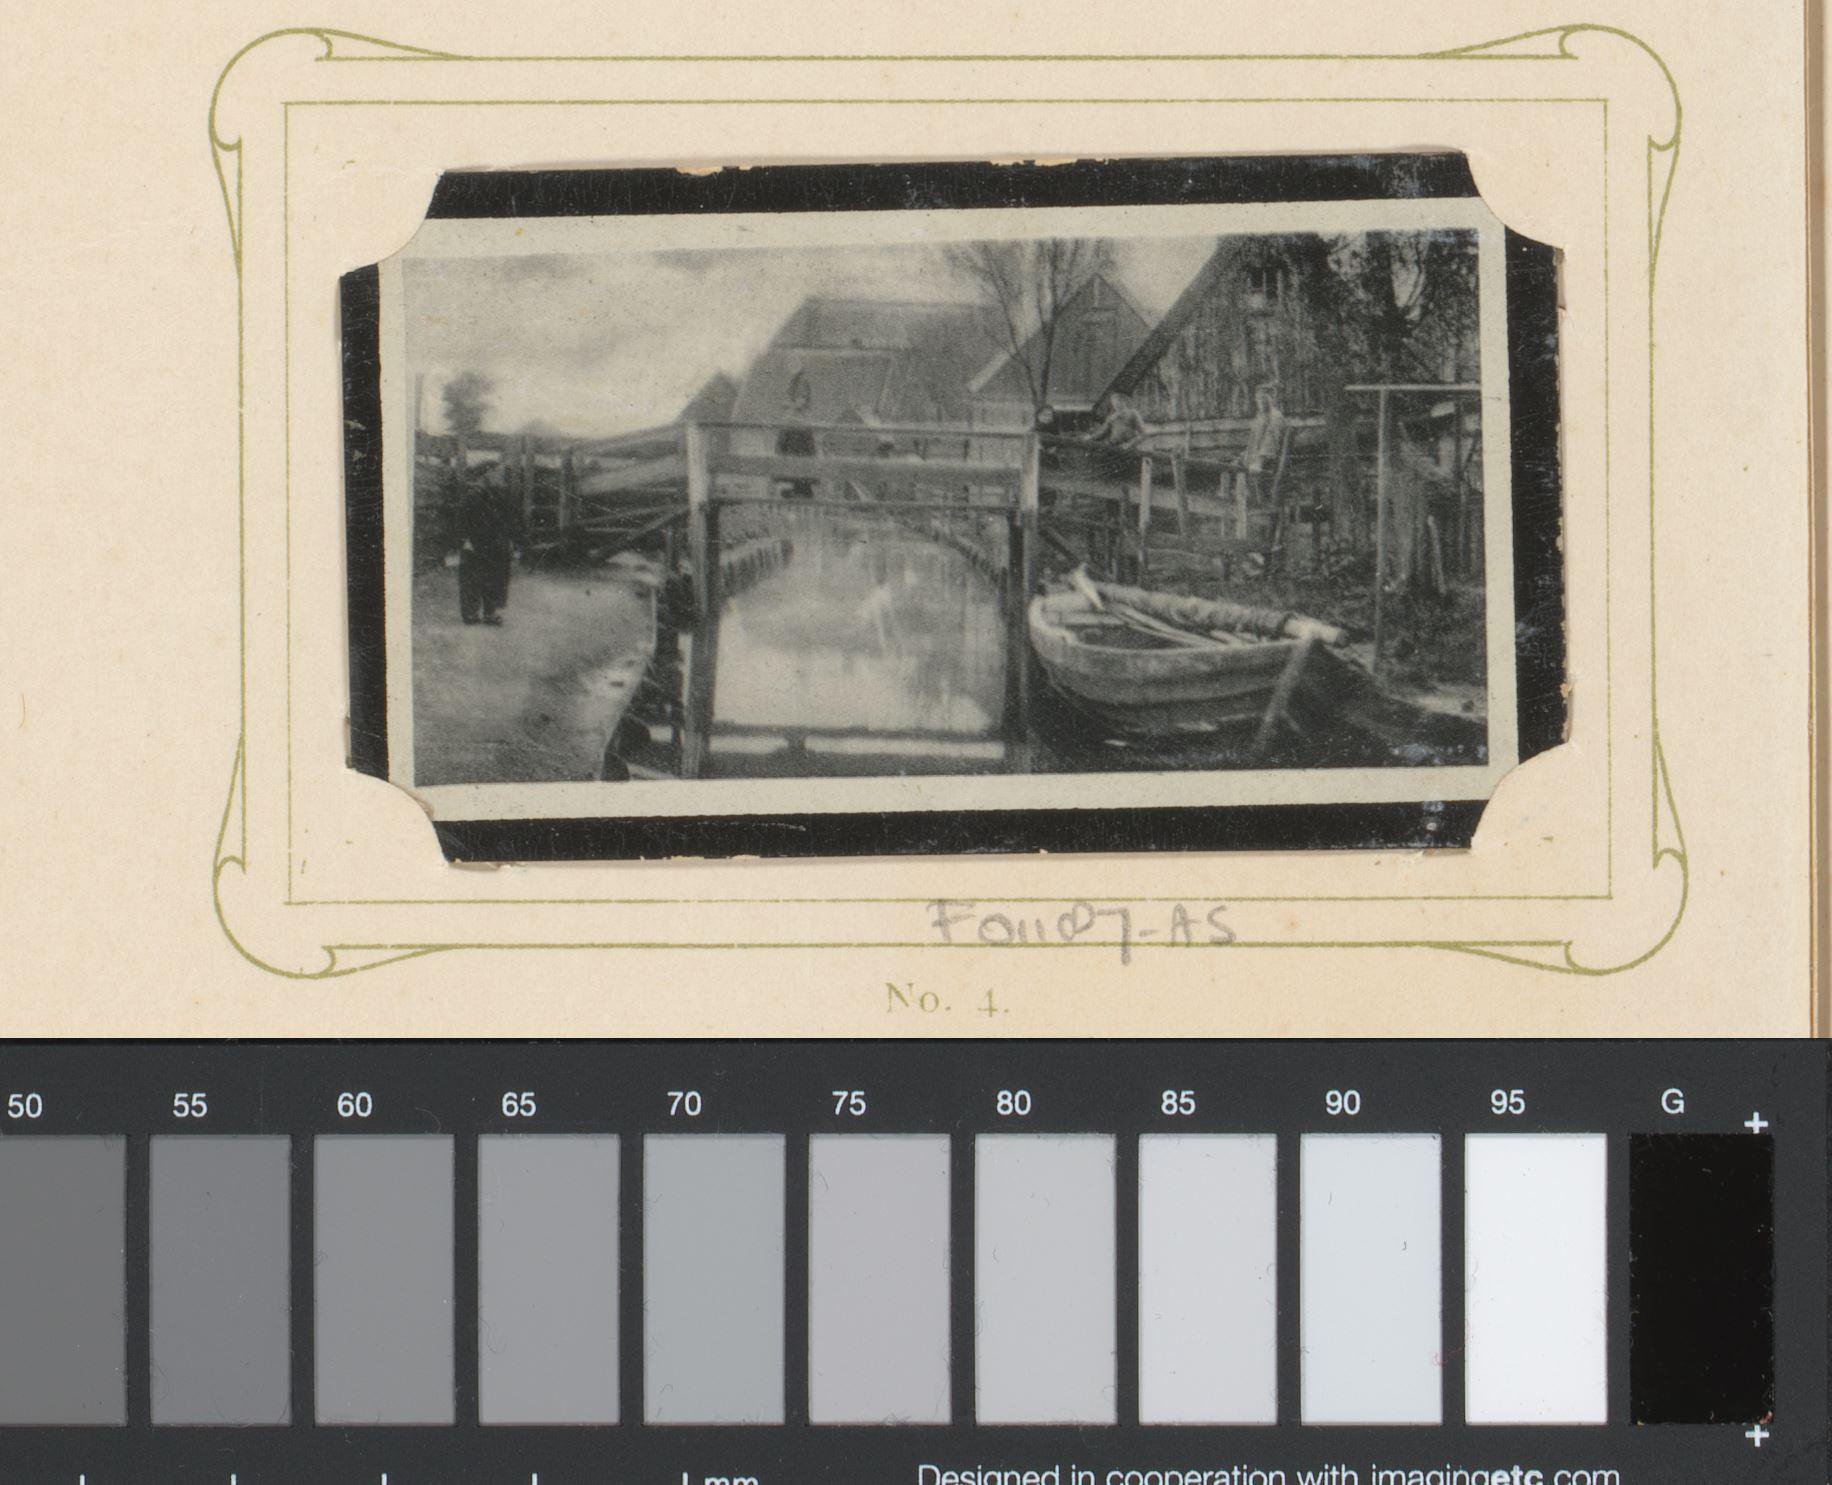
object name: album leaf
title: Vier personen op een kleine brug van hout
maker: Anonymous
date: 1905-1906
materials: paper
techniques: photograph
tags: bridge (+ four persons or more ~ traffic and transport)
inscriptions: inscription: ‘No. 4./ Op het bruggetje.’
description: Deze prent maakt deel uit van een album.